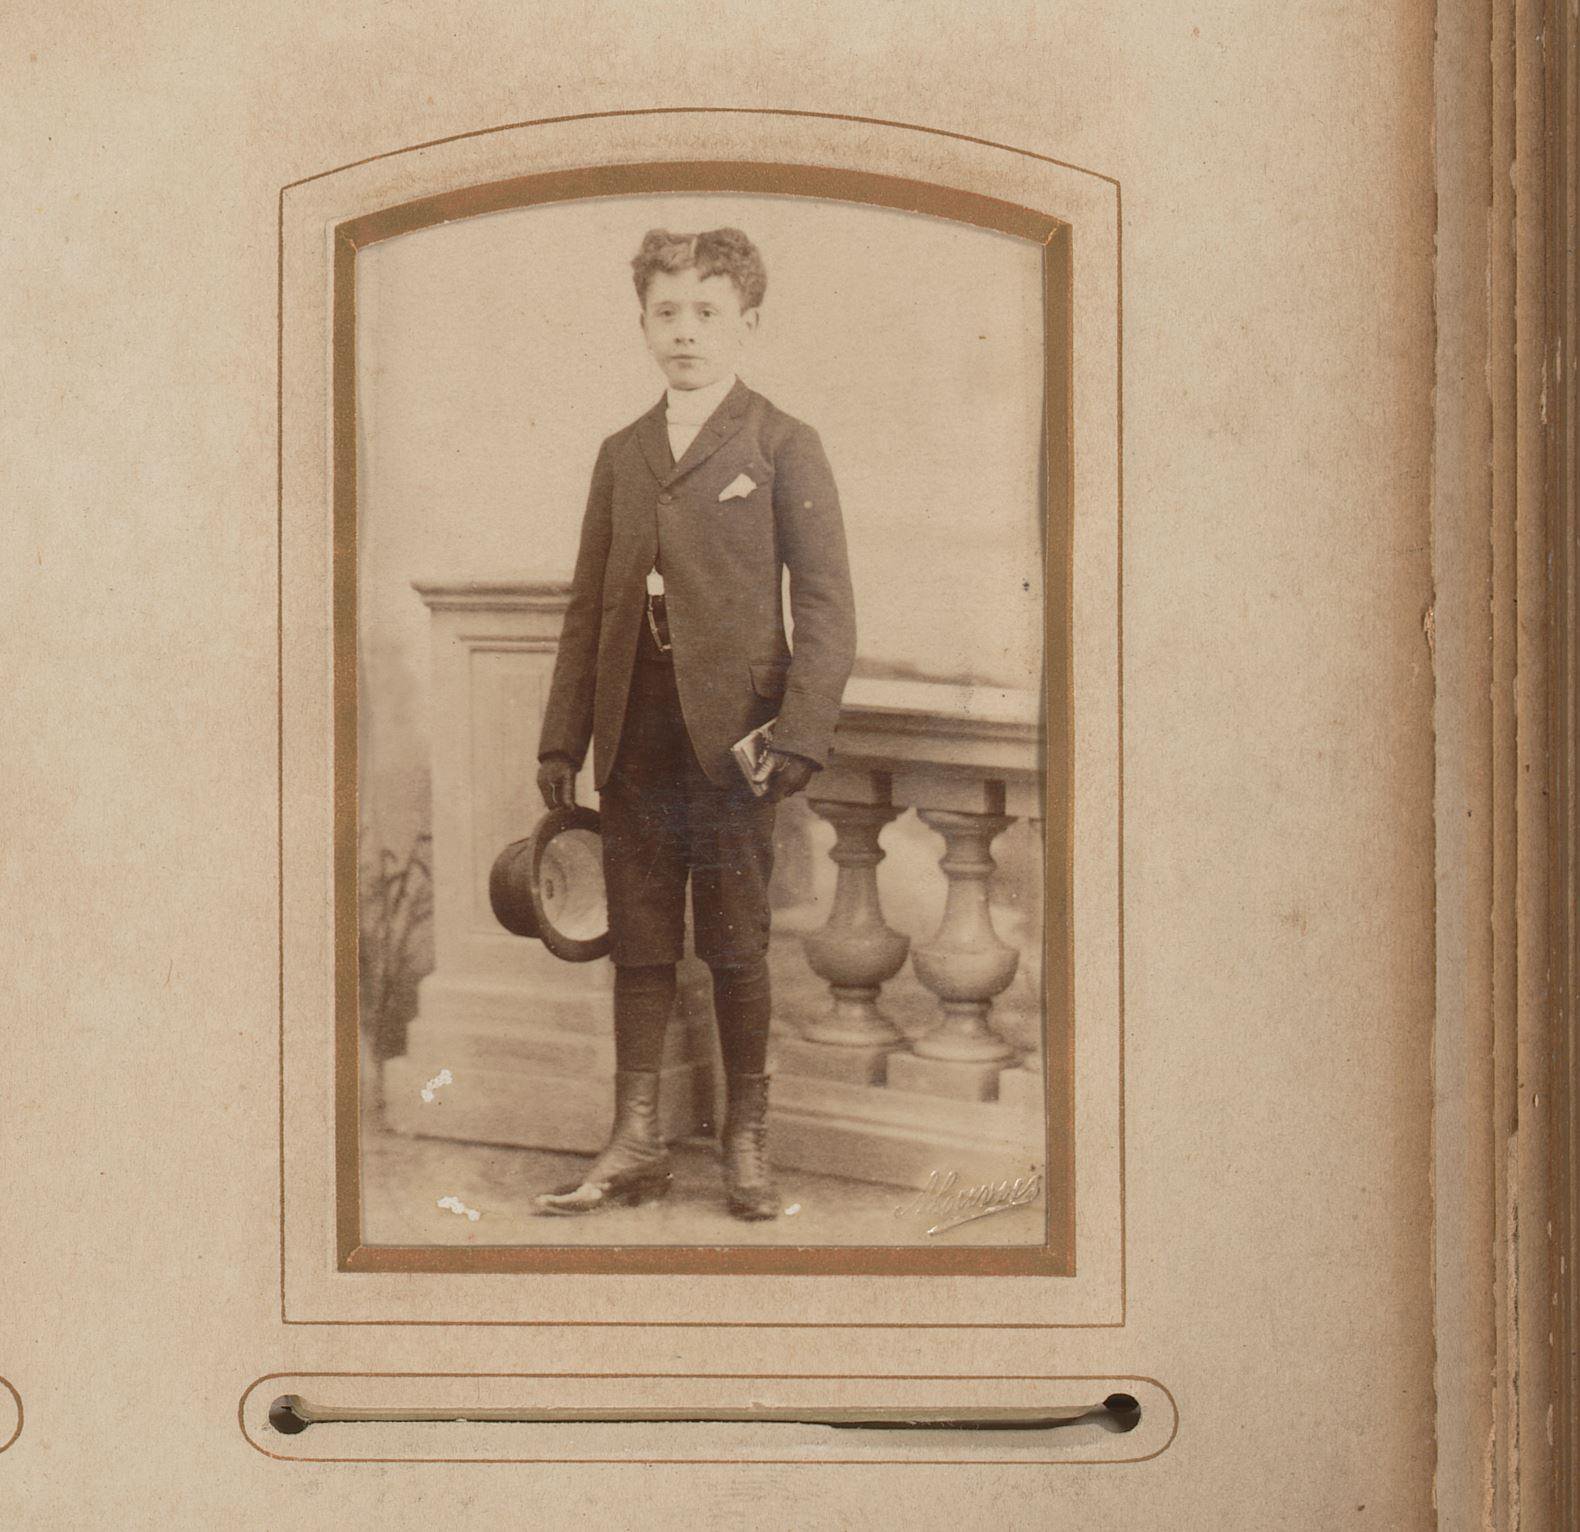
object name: semi enamel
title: Portret van een staande jongen met hoge hoed in de hand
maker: adrien louvois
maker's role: fotograaf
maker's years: 1851-1930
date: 1882-1911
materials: cardboard, celluloid, photographic support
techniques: albumen print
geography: sint-joost-ten-node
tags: boy (child between toddler and youth), historical persons, head-gear: top hat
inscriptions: inscription: ‘[Photographie/ Artistique Instantanée/ Reproduction sur porcelaine/ Impression aux encres grasses/ A. Louvois/ 51/ CHAUSSÉE de LOUVAIN/ lez-BRUXELLES/ Agrandissement en toute dimension/ peinture et encadrements./ Les clichés sont conservés.]’